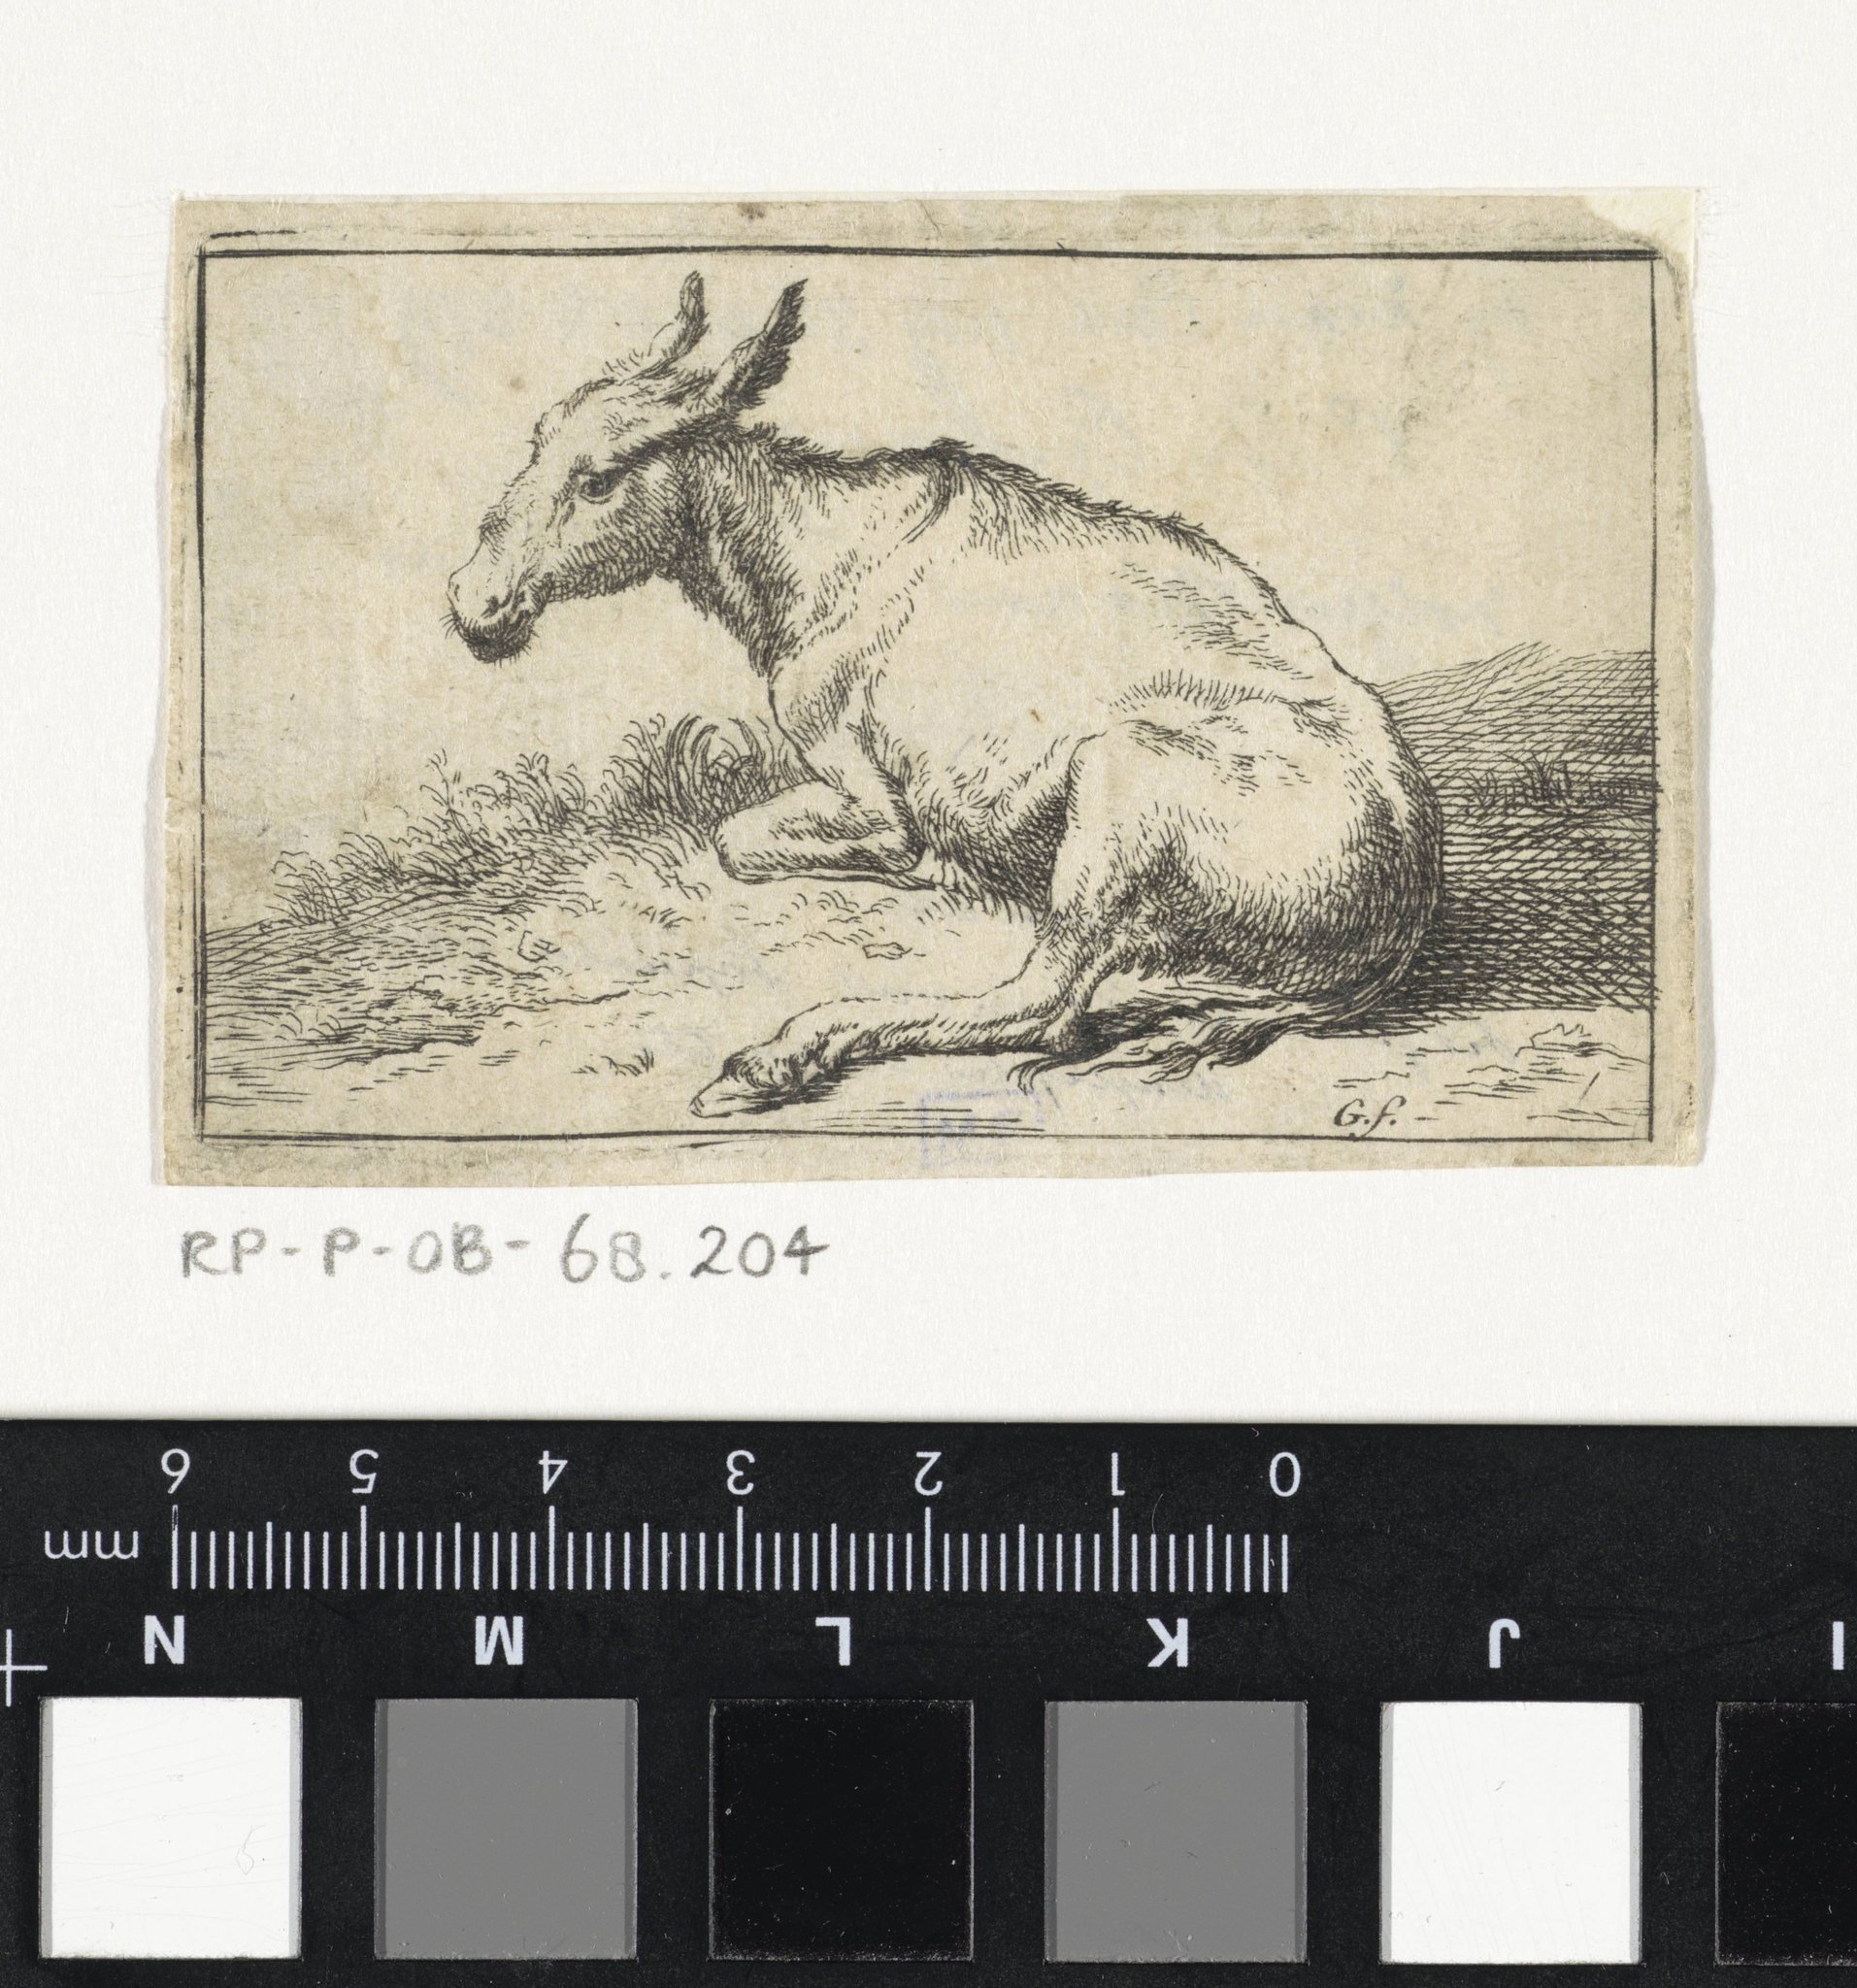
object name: print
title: Liggende ezel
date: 1750-1830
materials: paper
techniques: etching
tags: ass, donkey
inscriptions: collector's mark: Lugt 2227